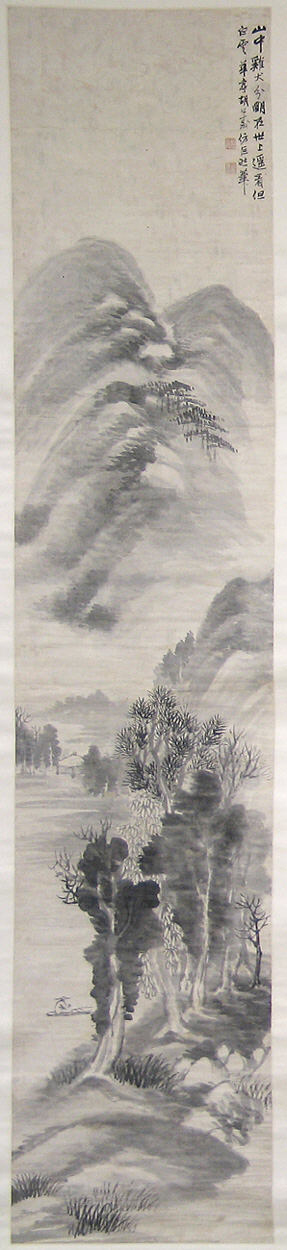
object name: hanging scroll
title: Landscapes of the Four Seasons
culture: chinese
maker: hu yuan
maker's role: artist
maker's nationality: chinese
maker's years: 1823-1886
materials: ink, paper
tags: mountains,landscapes